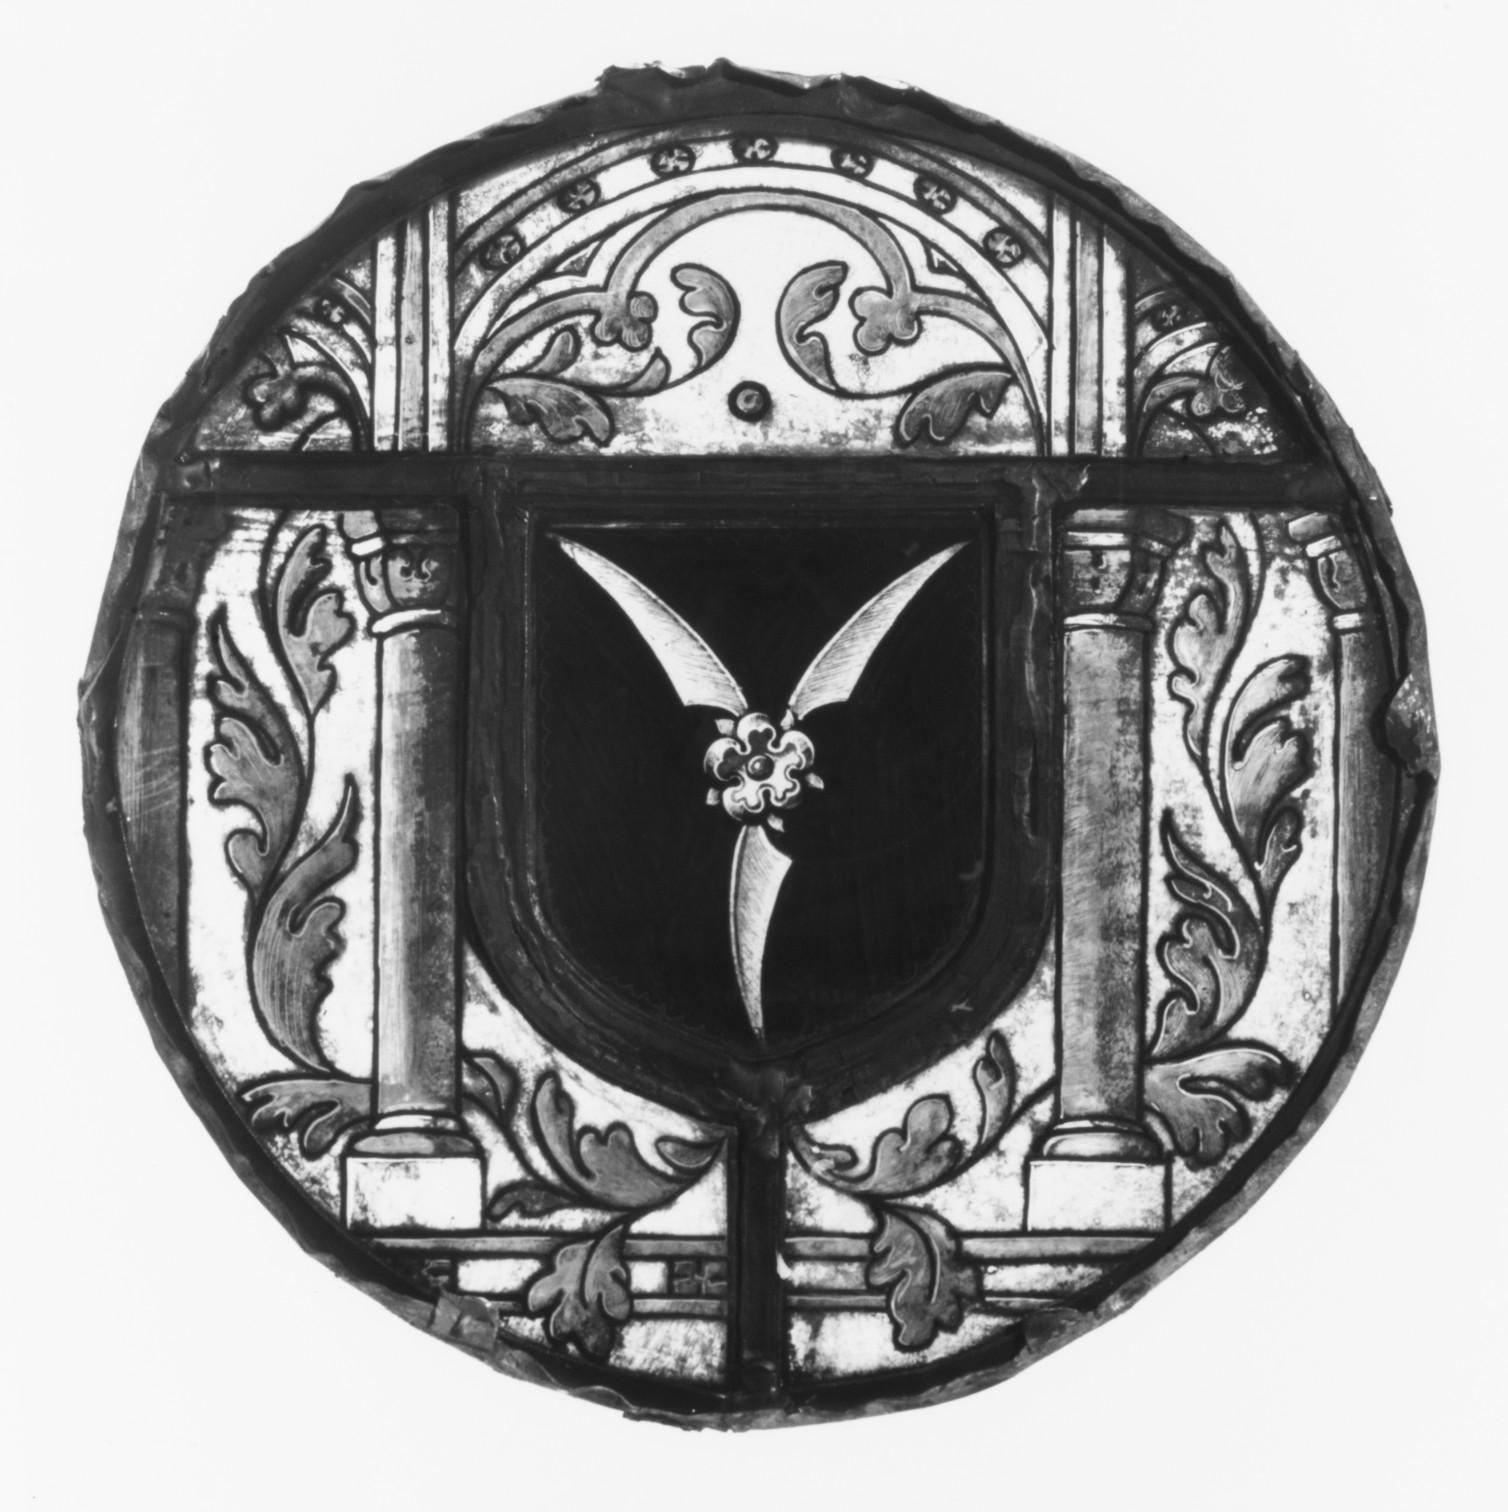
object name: armorial panel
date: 1567-1600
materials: glass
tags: leaves